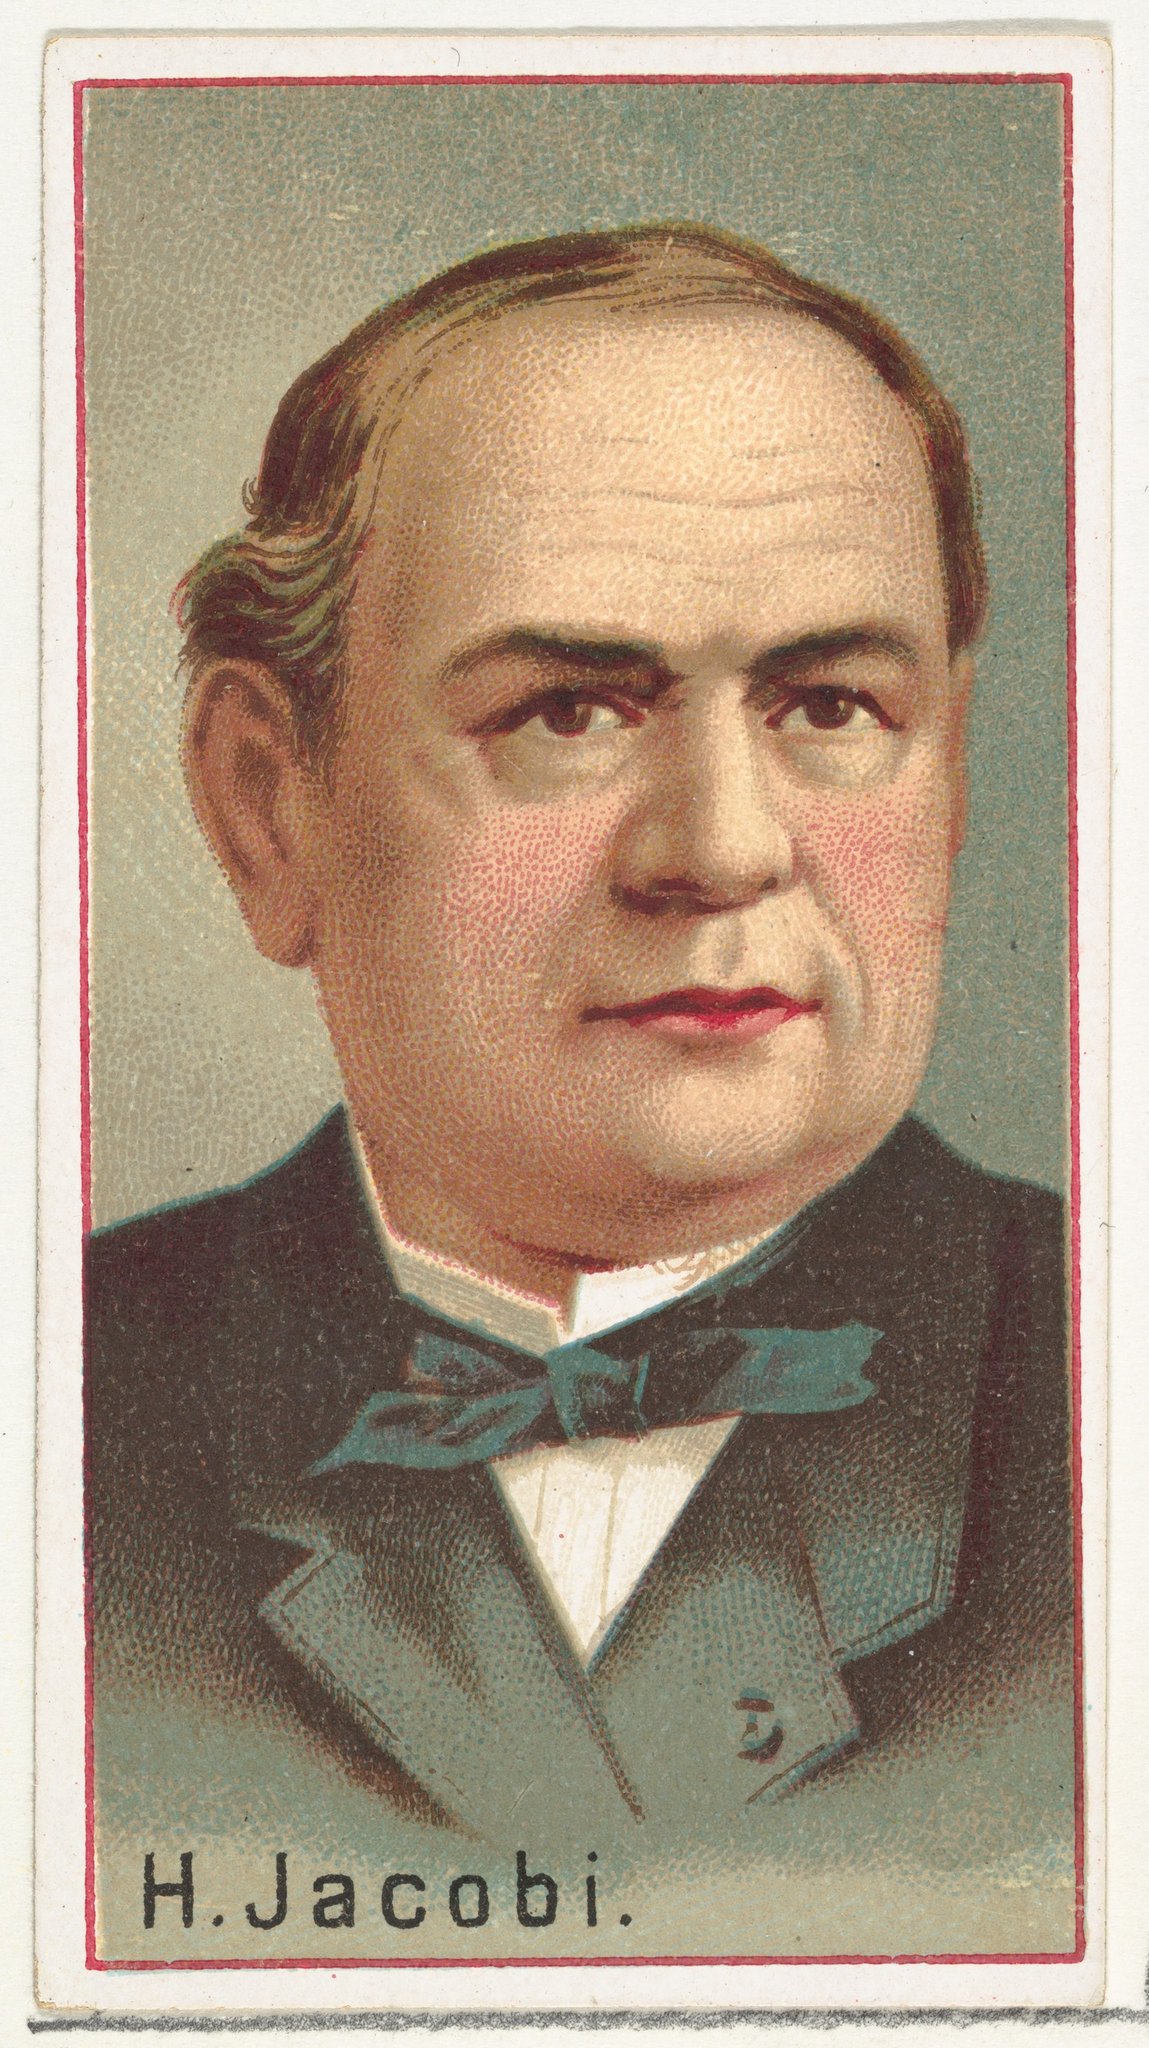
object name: print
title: H. Jacobi, printer's sample for the World's Inventors souvenir album (A25) for Allen & Ginter Cigarettes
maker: allen & ginter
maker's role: publisher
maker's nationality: american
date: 1888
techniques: color lithograph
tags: men,portraits